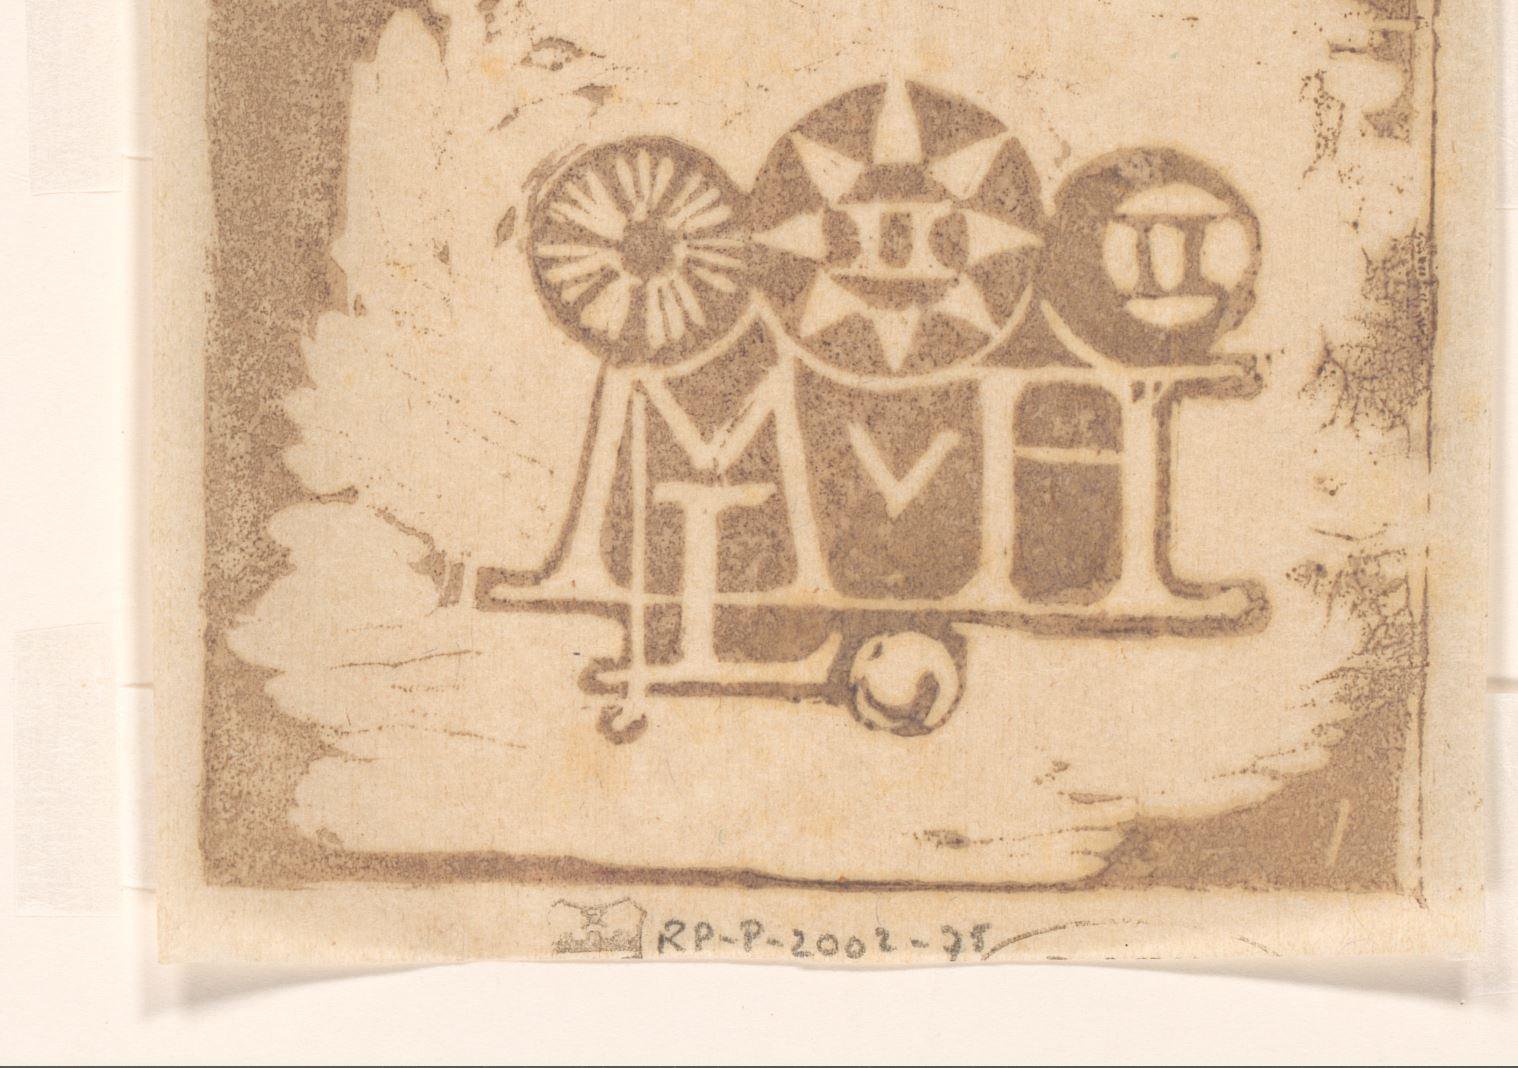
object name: print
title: Vignet met monogram MLvH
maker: bernard willem wierink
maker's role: draughtsman, print maker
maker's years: 1856-1939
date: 1871-1939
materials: paper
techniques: relief print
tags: vignette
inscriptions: collector's mark: Lugt 2228, collector's mark: Lugt 2760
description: Deze prent is vermoedelijk een plaatsnede, ook al wordt in de literatuur veelal gesproken over een houtsnede. Voor zover Wierink zijn prenten in hoogdruk zelf nader heeft omschreven, heeft hij altijd de term 'plaatsnede' gebruikt.